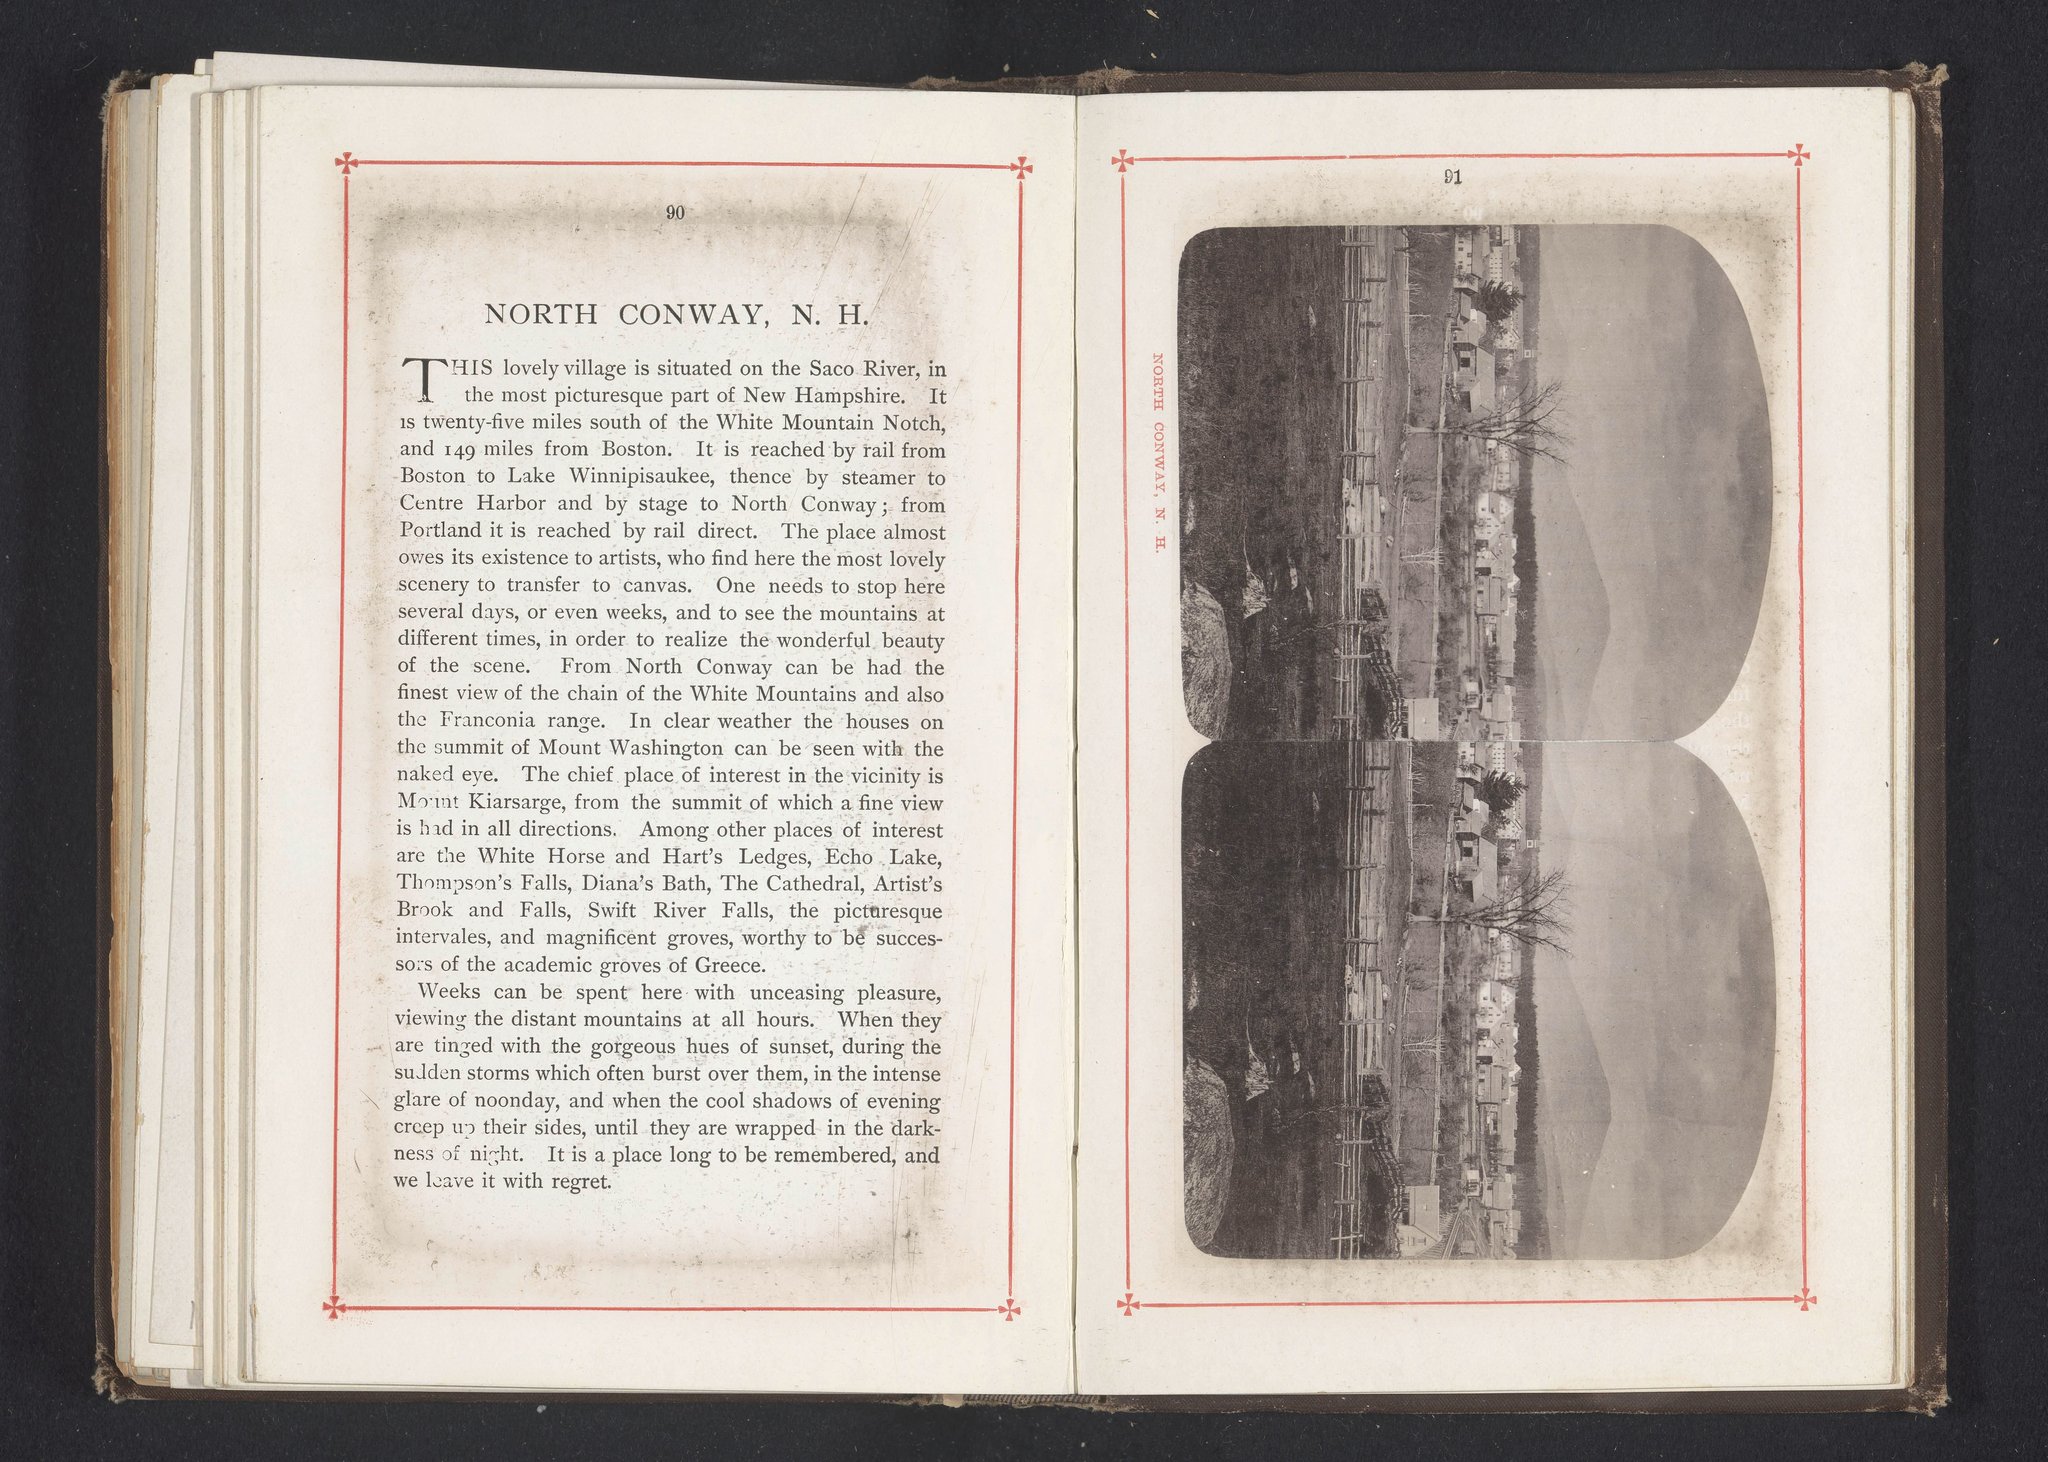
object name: stereograph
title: North Conway, N.H.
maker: Anonymous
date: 1873-1878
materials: paper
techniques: photograph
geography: north conway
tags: city-view in general; 'veduta', mountains